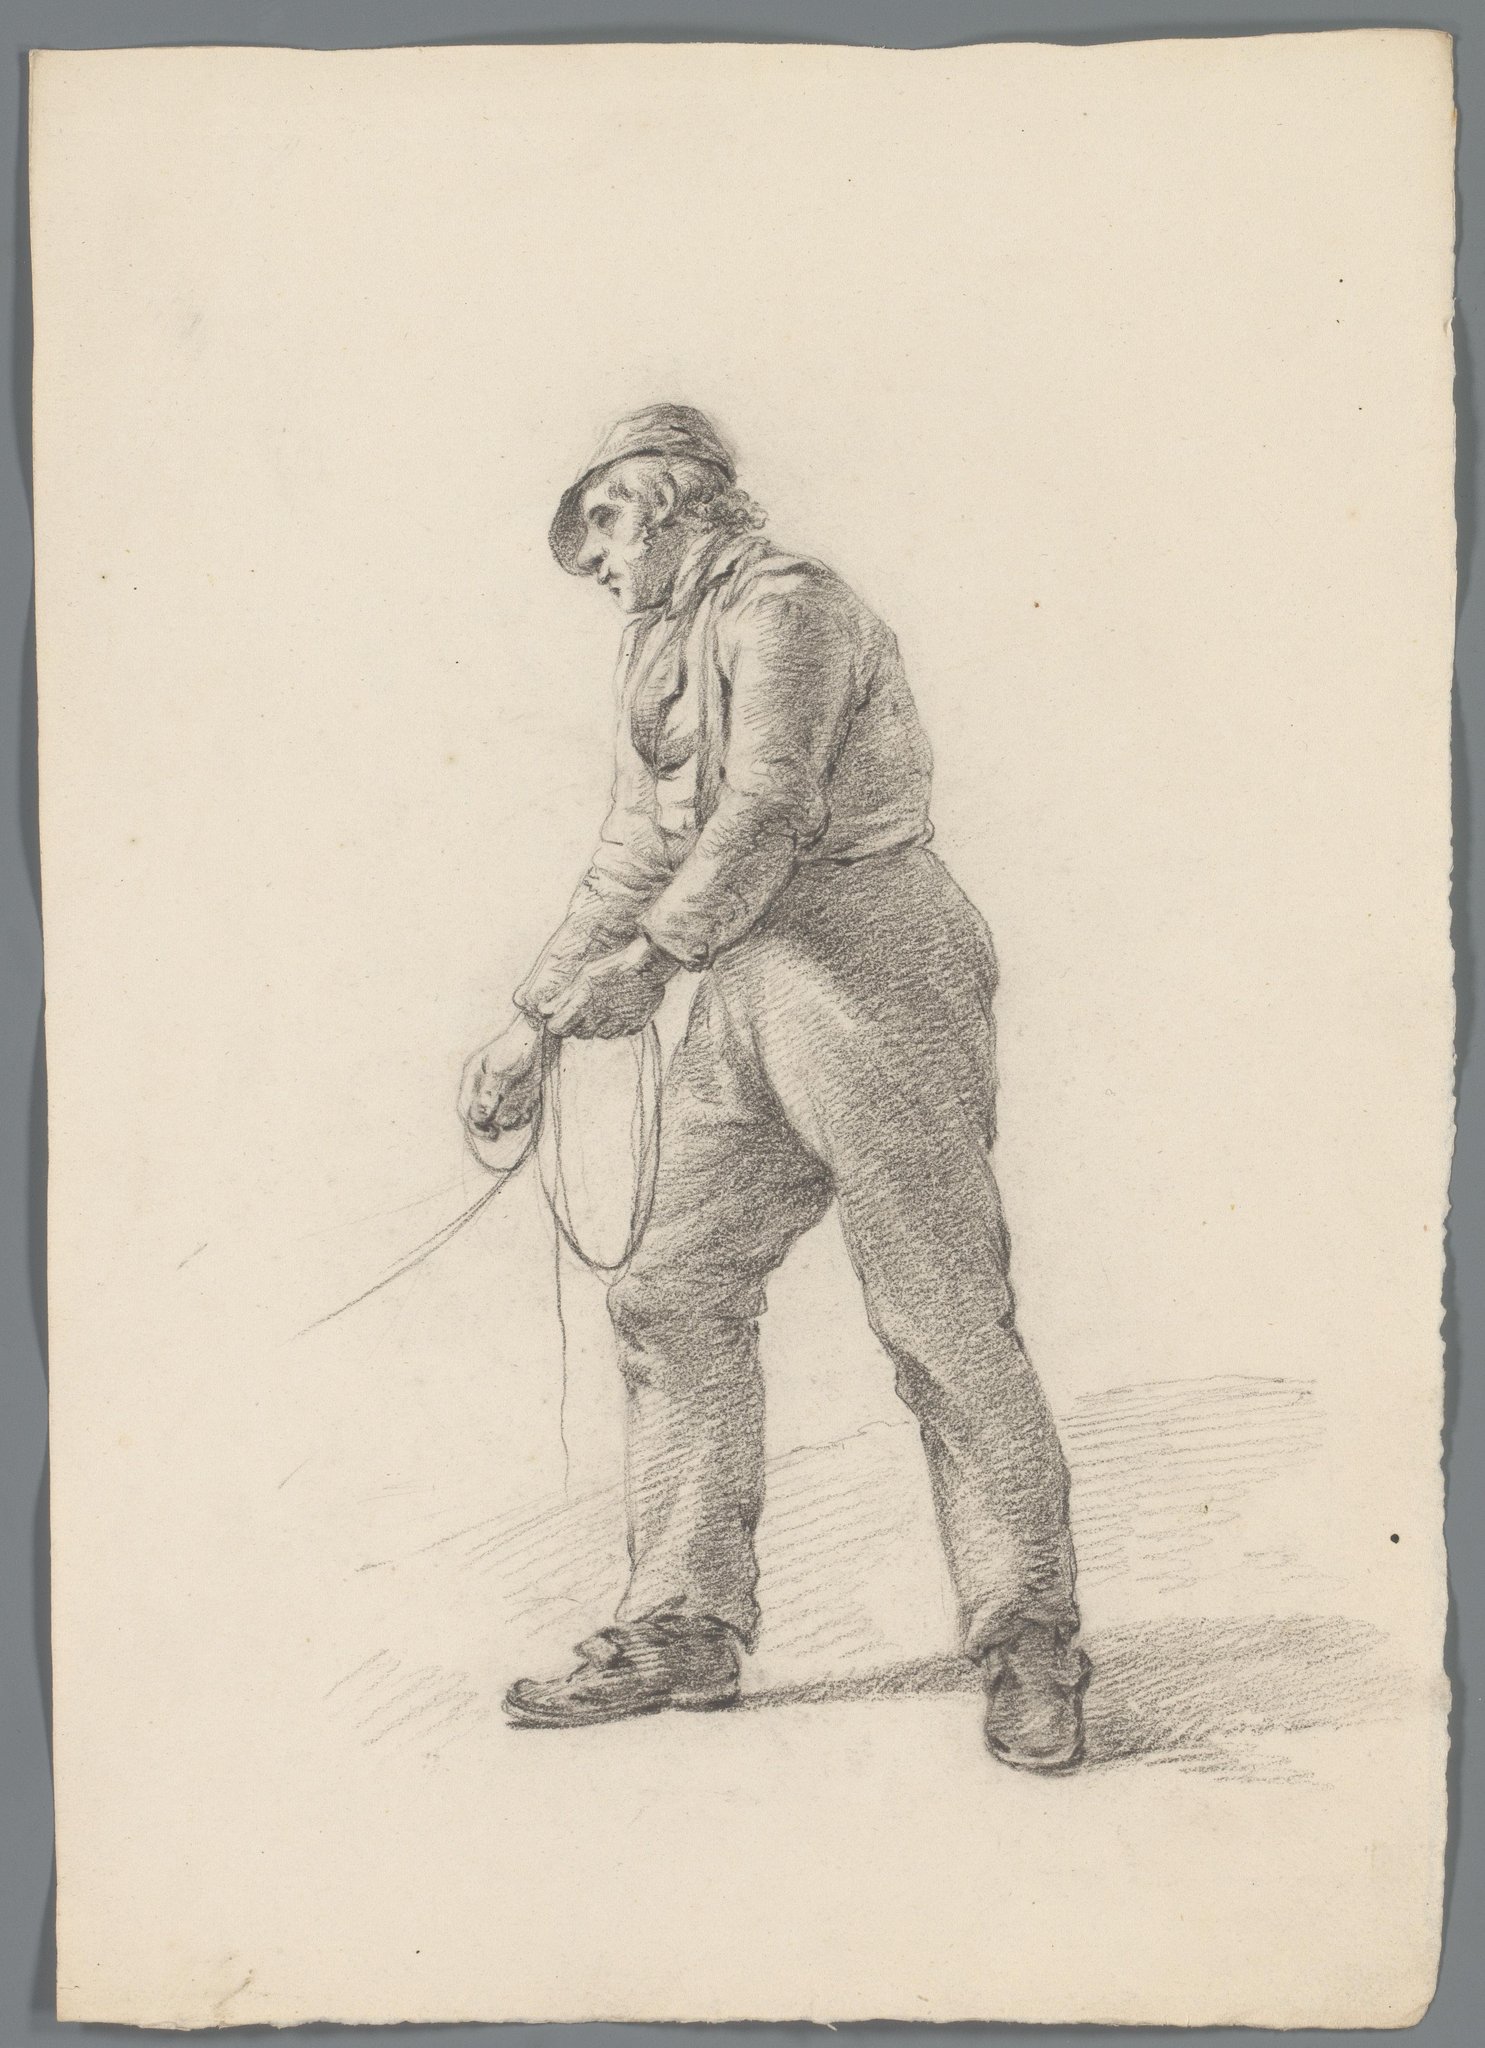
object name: drawing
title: Man met een touw in zijn handen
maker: Anonymous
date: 1820-1830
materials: chalk, paper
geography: the hague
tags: adult man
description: Tekeningen waarschijnlijk ontstaan bij het Haagse kunstgenootschap ‘Tot Nut der Tekenkunst’, waar twee keer per week tekenavonden werden georganiseerd met geklede modellen.